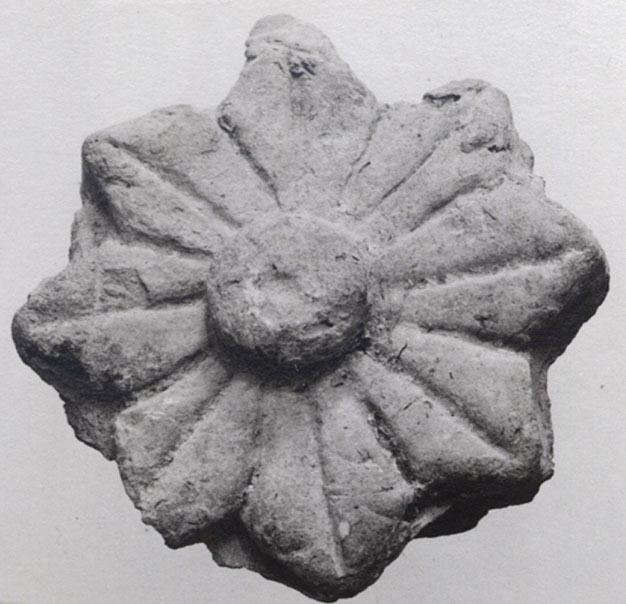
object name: molded fragment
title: Molded Appliqé Ornament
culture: west chinese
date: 101-500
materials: earthenware